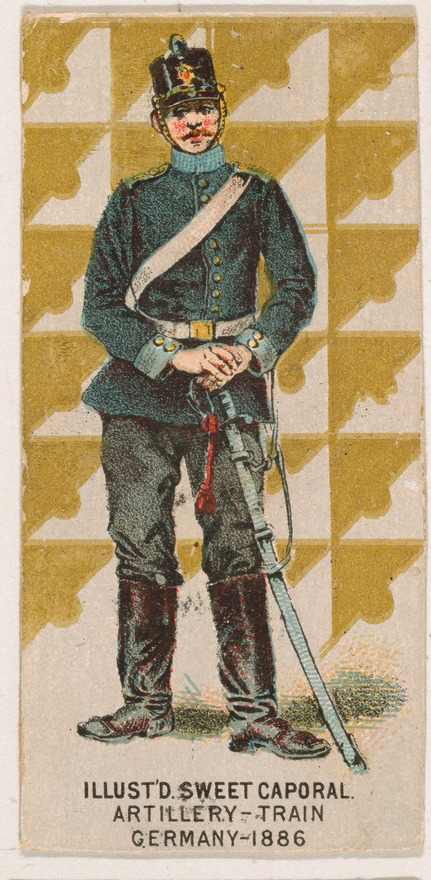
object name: print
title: Artillery, Train, Germany, 1886, from the Military Series (N224) issued by Kinney Tobacco Company to promote Sweet Caporal Cigarettes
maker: kinney brothers tobacco company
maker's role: publisher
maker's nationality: american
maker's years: 1869-2011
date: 1888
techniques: color lithograph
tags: military,swords,men